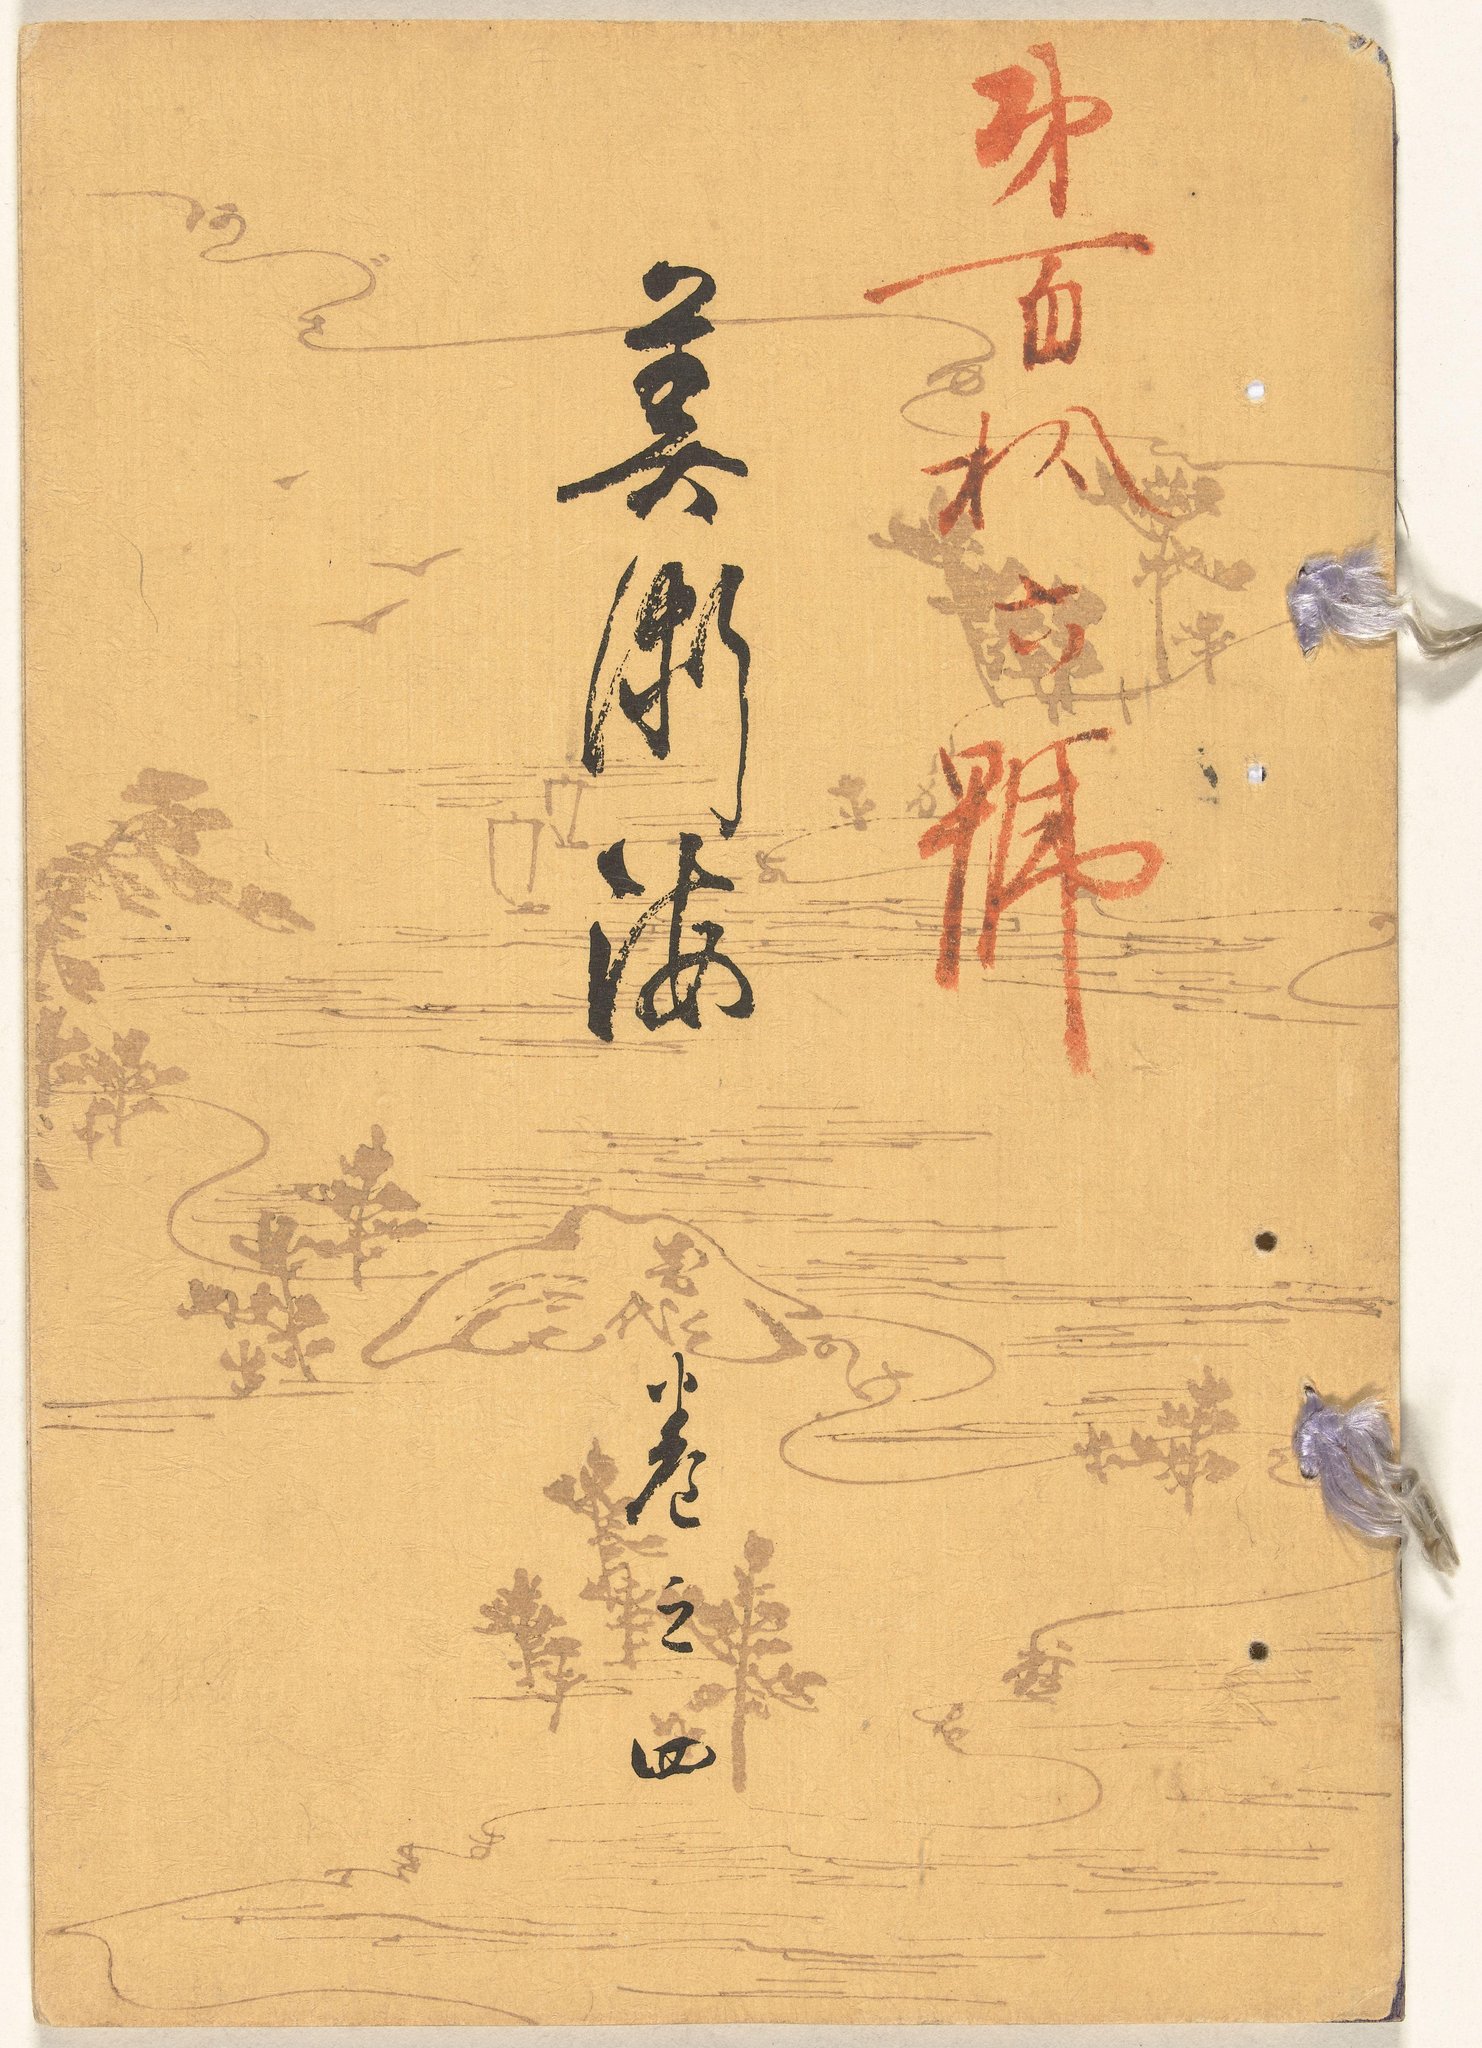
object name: book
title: Zee der kunsten - nummer vier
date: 1896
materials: paper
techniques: woodcut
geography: kyoto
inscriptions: date